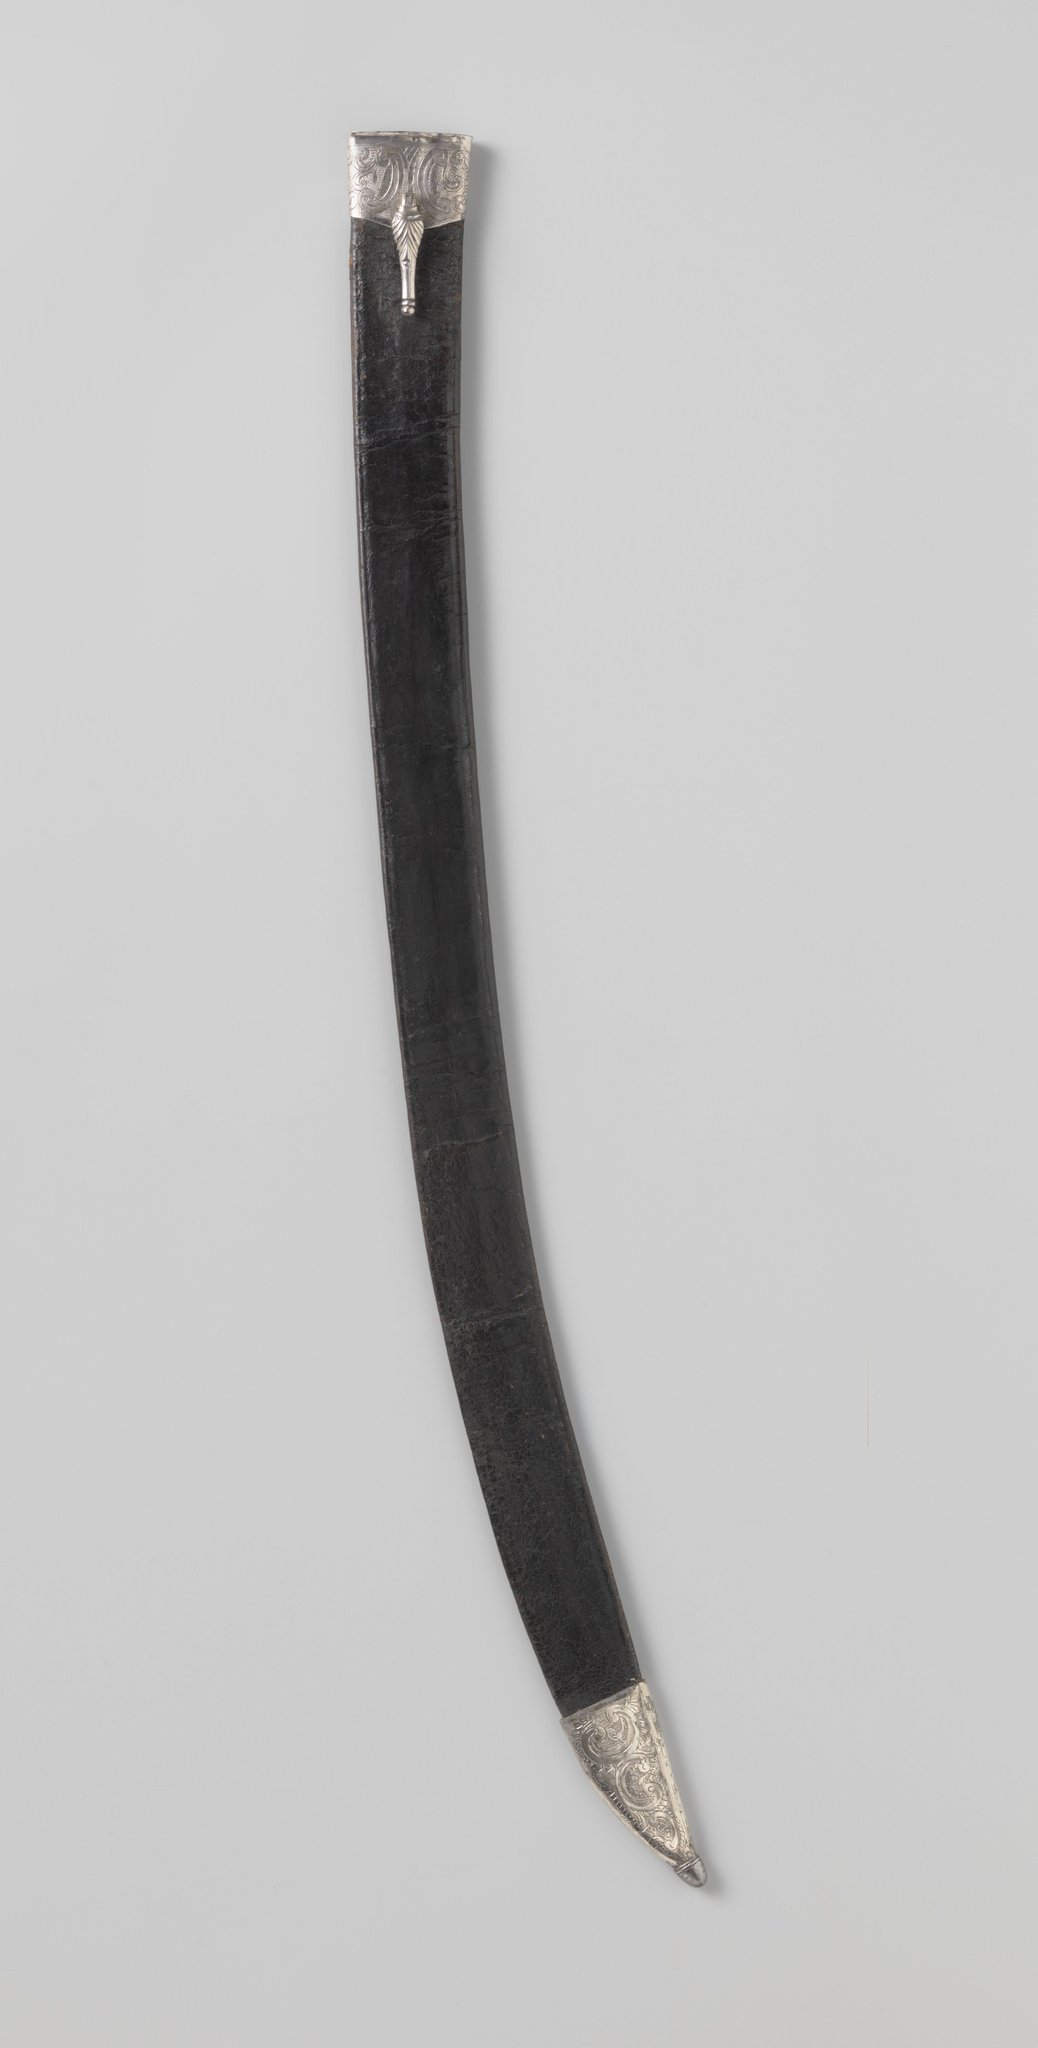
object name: knife with sheath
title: Schede horend bij de sabel van Maarten Harpertszn. Tromp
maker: Anonymous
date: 1650-1700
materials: leather, silver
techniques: engraving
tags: maarten harpertszoon tromp, ornaments ~ art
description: Lederen schede met gegraveerde zilveren montuur.